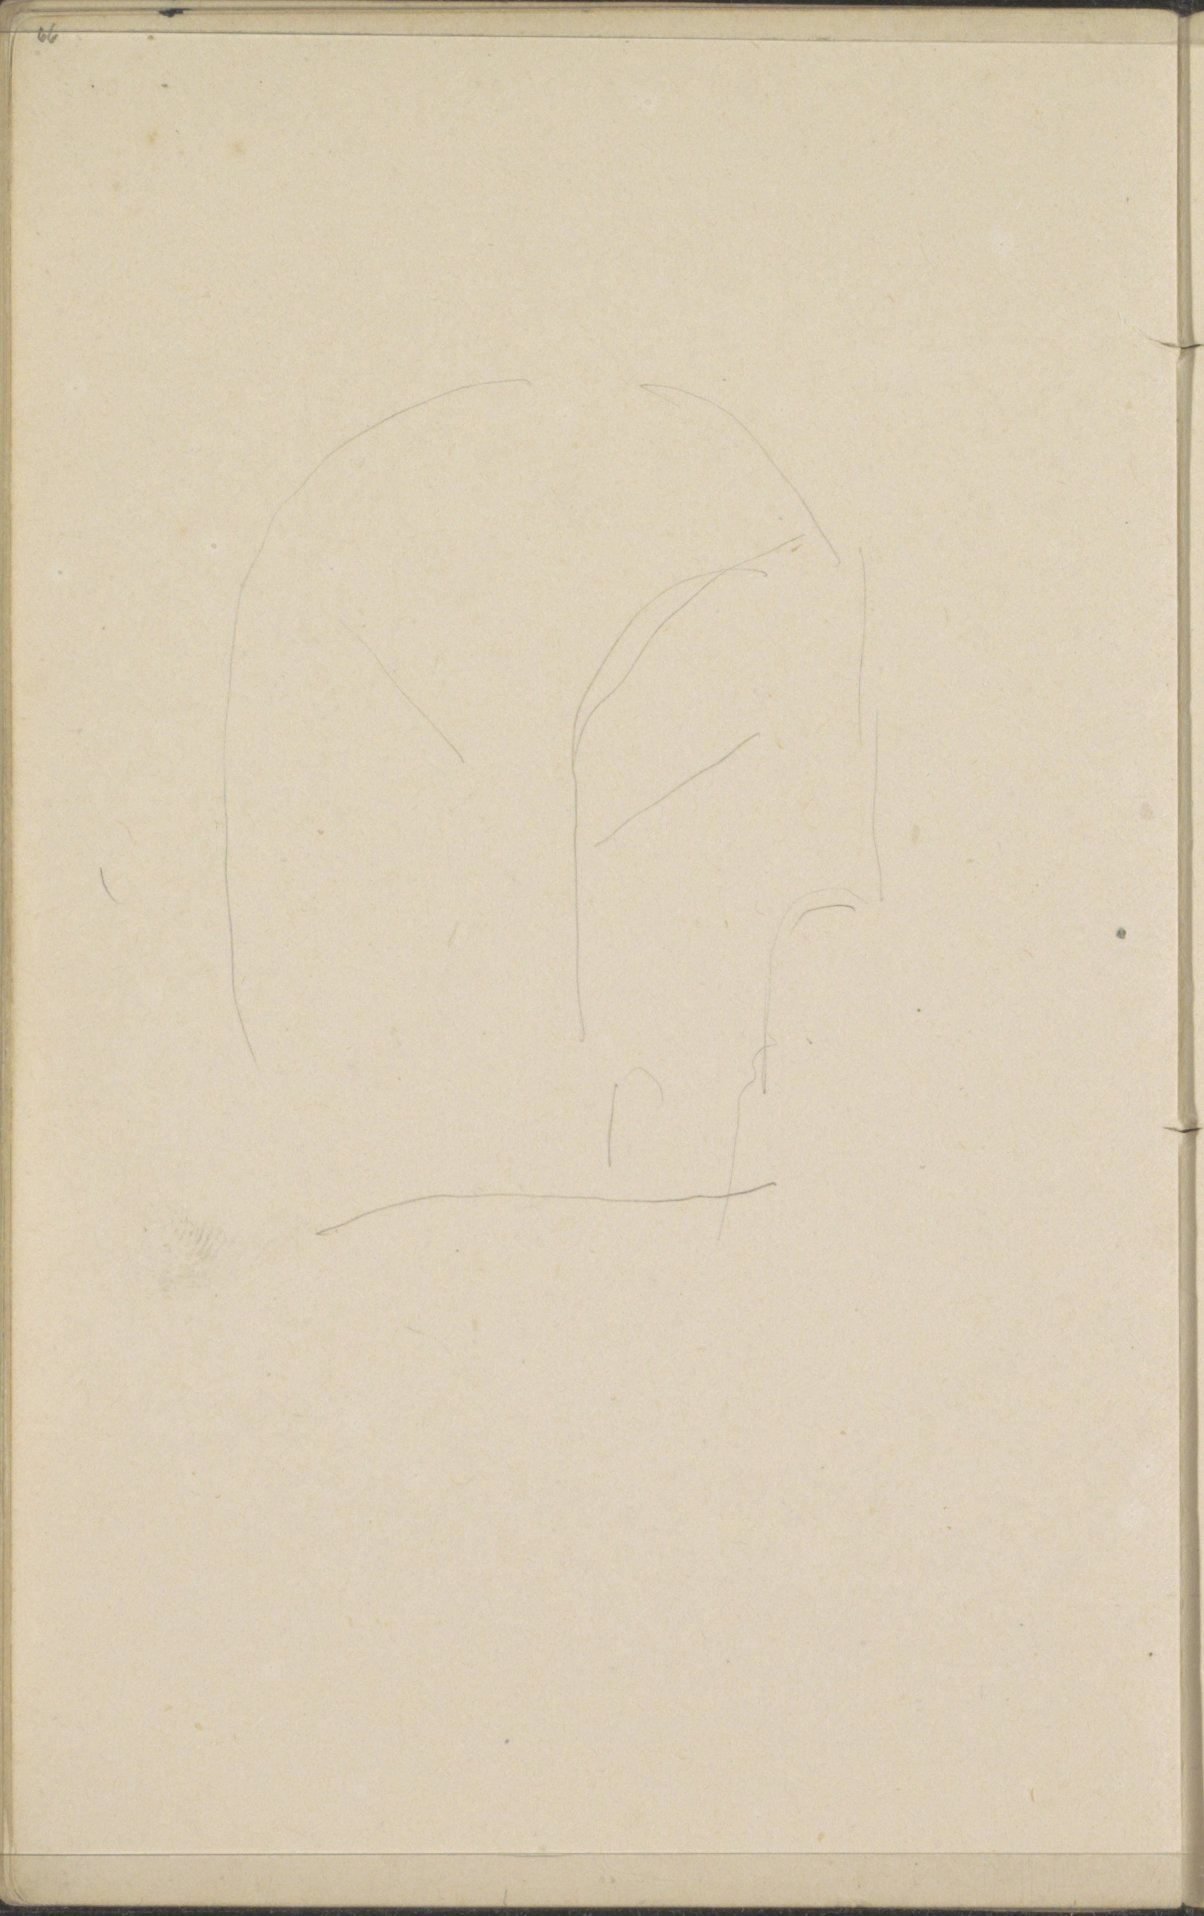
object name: sketchbook leaf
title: Architectuurstudie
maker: marius bauer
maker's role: draughtsman, print maker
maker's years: 1867-1932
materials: paper, pencil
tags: arch, archivolt ~ architecture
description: Pagina 66 uit een schetsboek met 36 bladen.